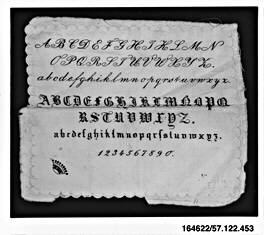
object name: sampler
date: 1801-1900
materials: cotton, linen